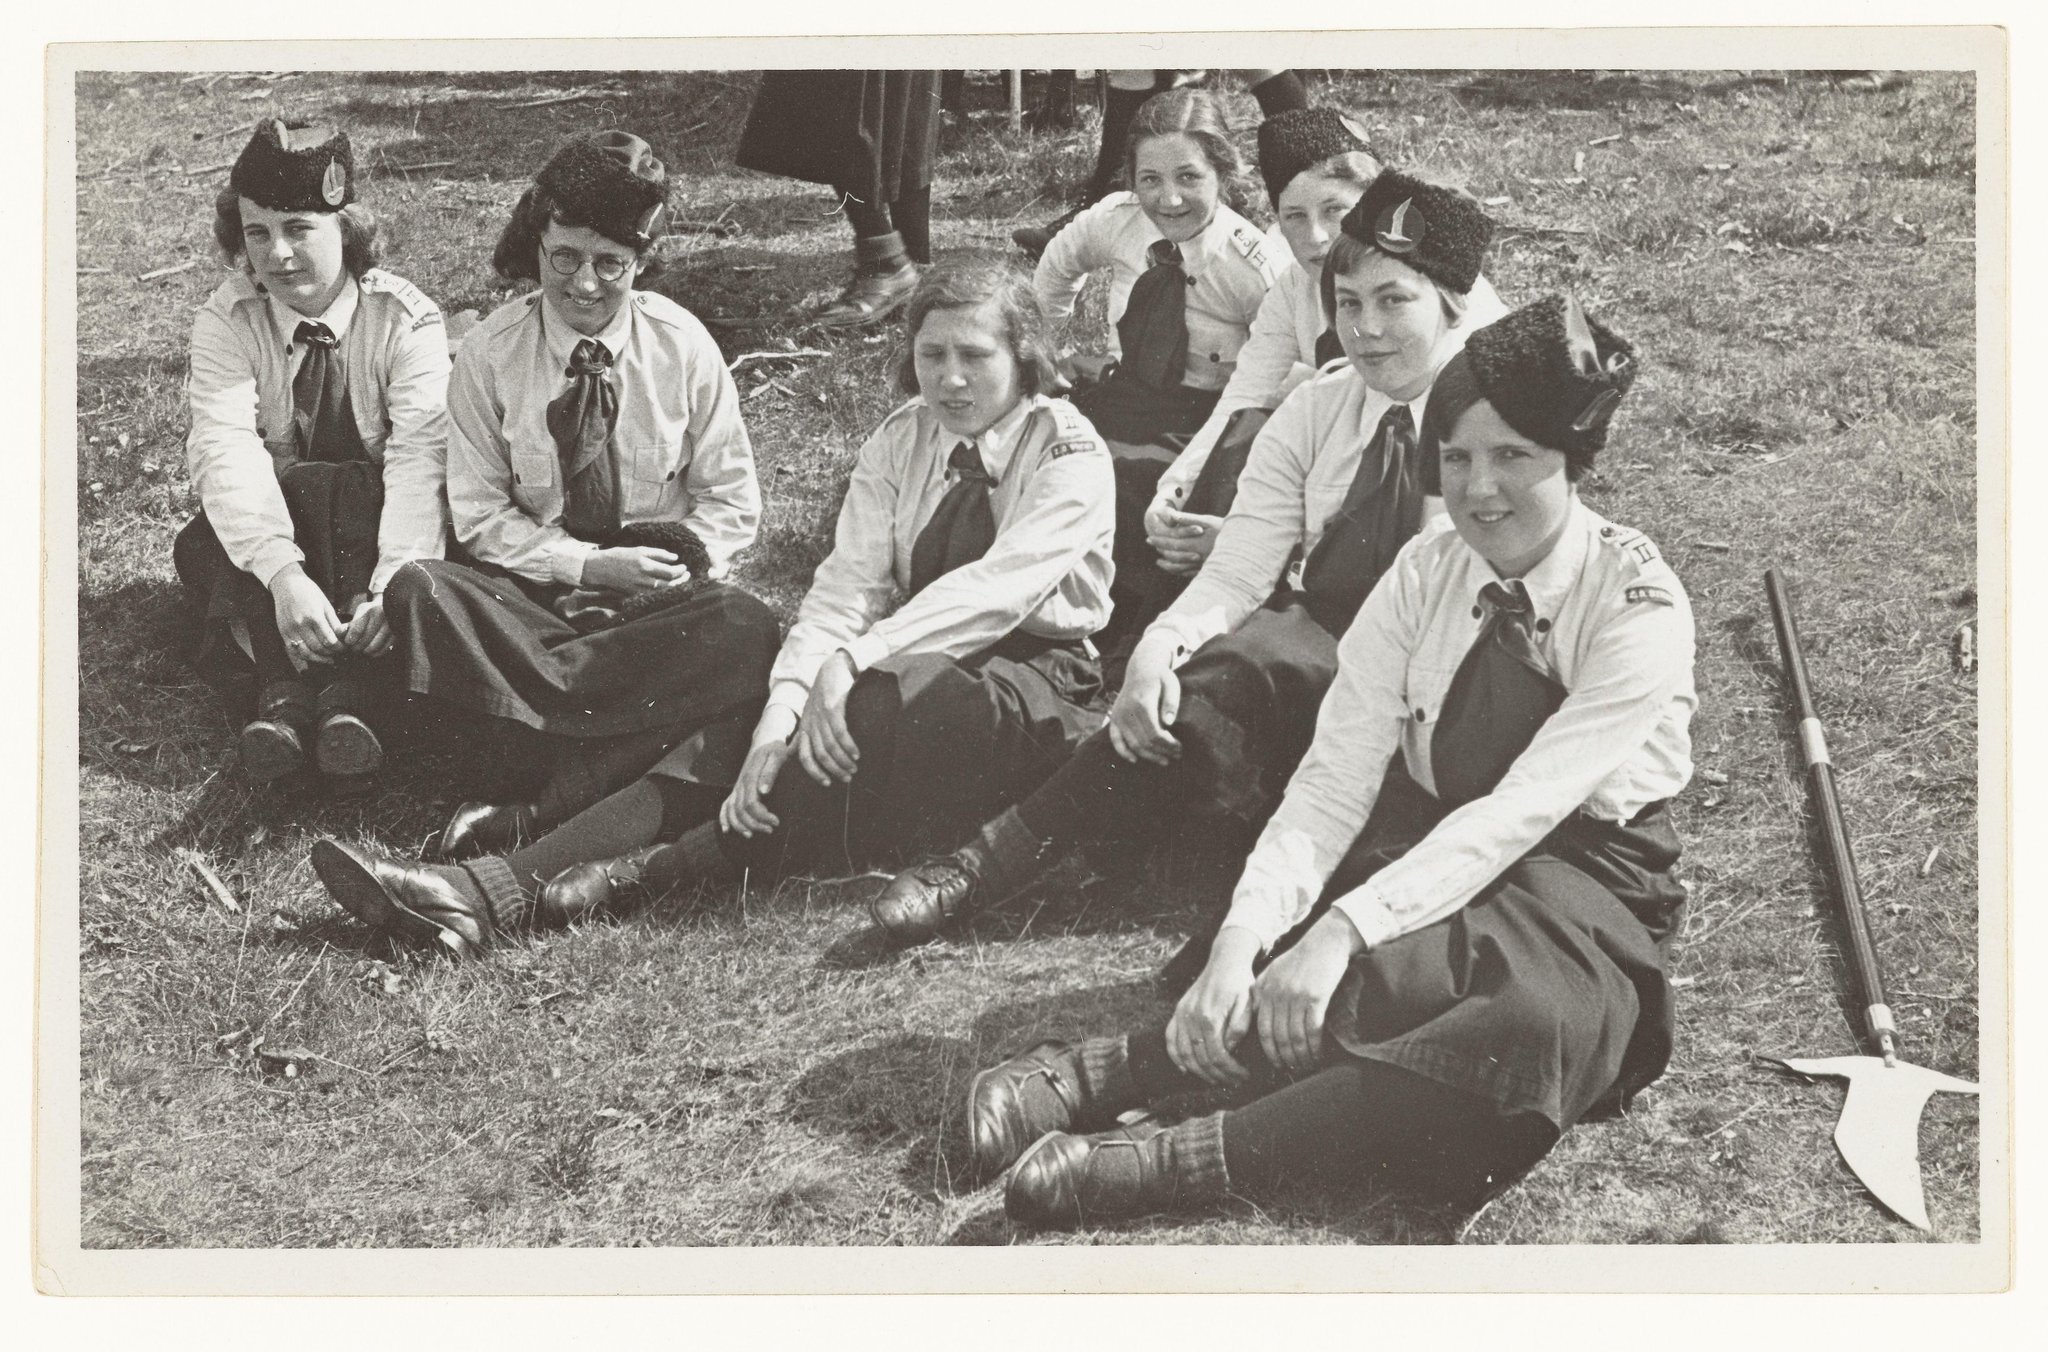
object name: photograph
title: Jeugdstorm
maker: j. otto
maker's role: fotograaf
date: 1935-1937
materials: photographic support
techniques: gelatin silver print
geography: zeist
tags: military parade, pageant, zeist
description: Op de grond zitten zeven vrouwelijke leden van de Jeugdstorm, vermoedelijk na afloop van de optocht. Rechts op de grond ligt een vlaggestok met bovenop de versiering met de vliegende meeuw. Het symool van de jeugdstorm. Een aantal van de stormsters dragen op hun mouw een bandje met het woord 't Sticht en daarboven een Romeinse II.